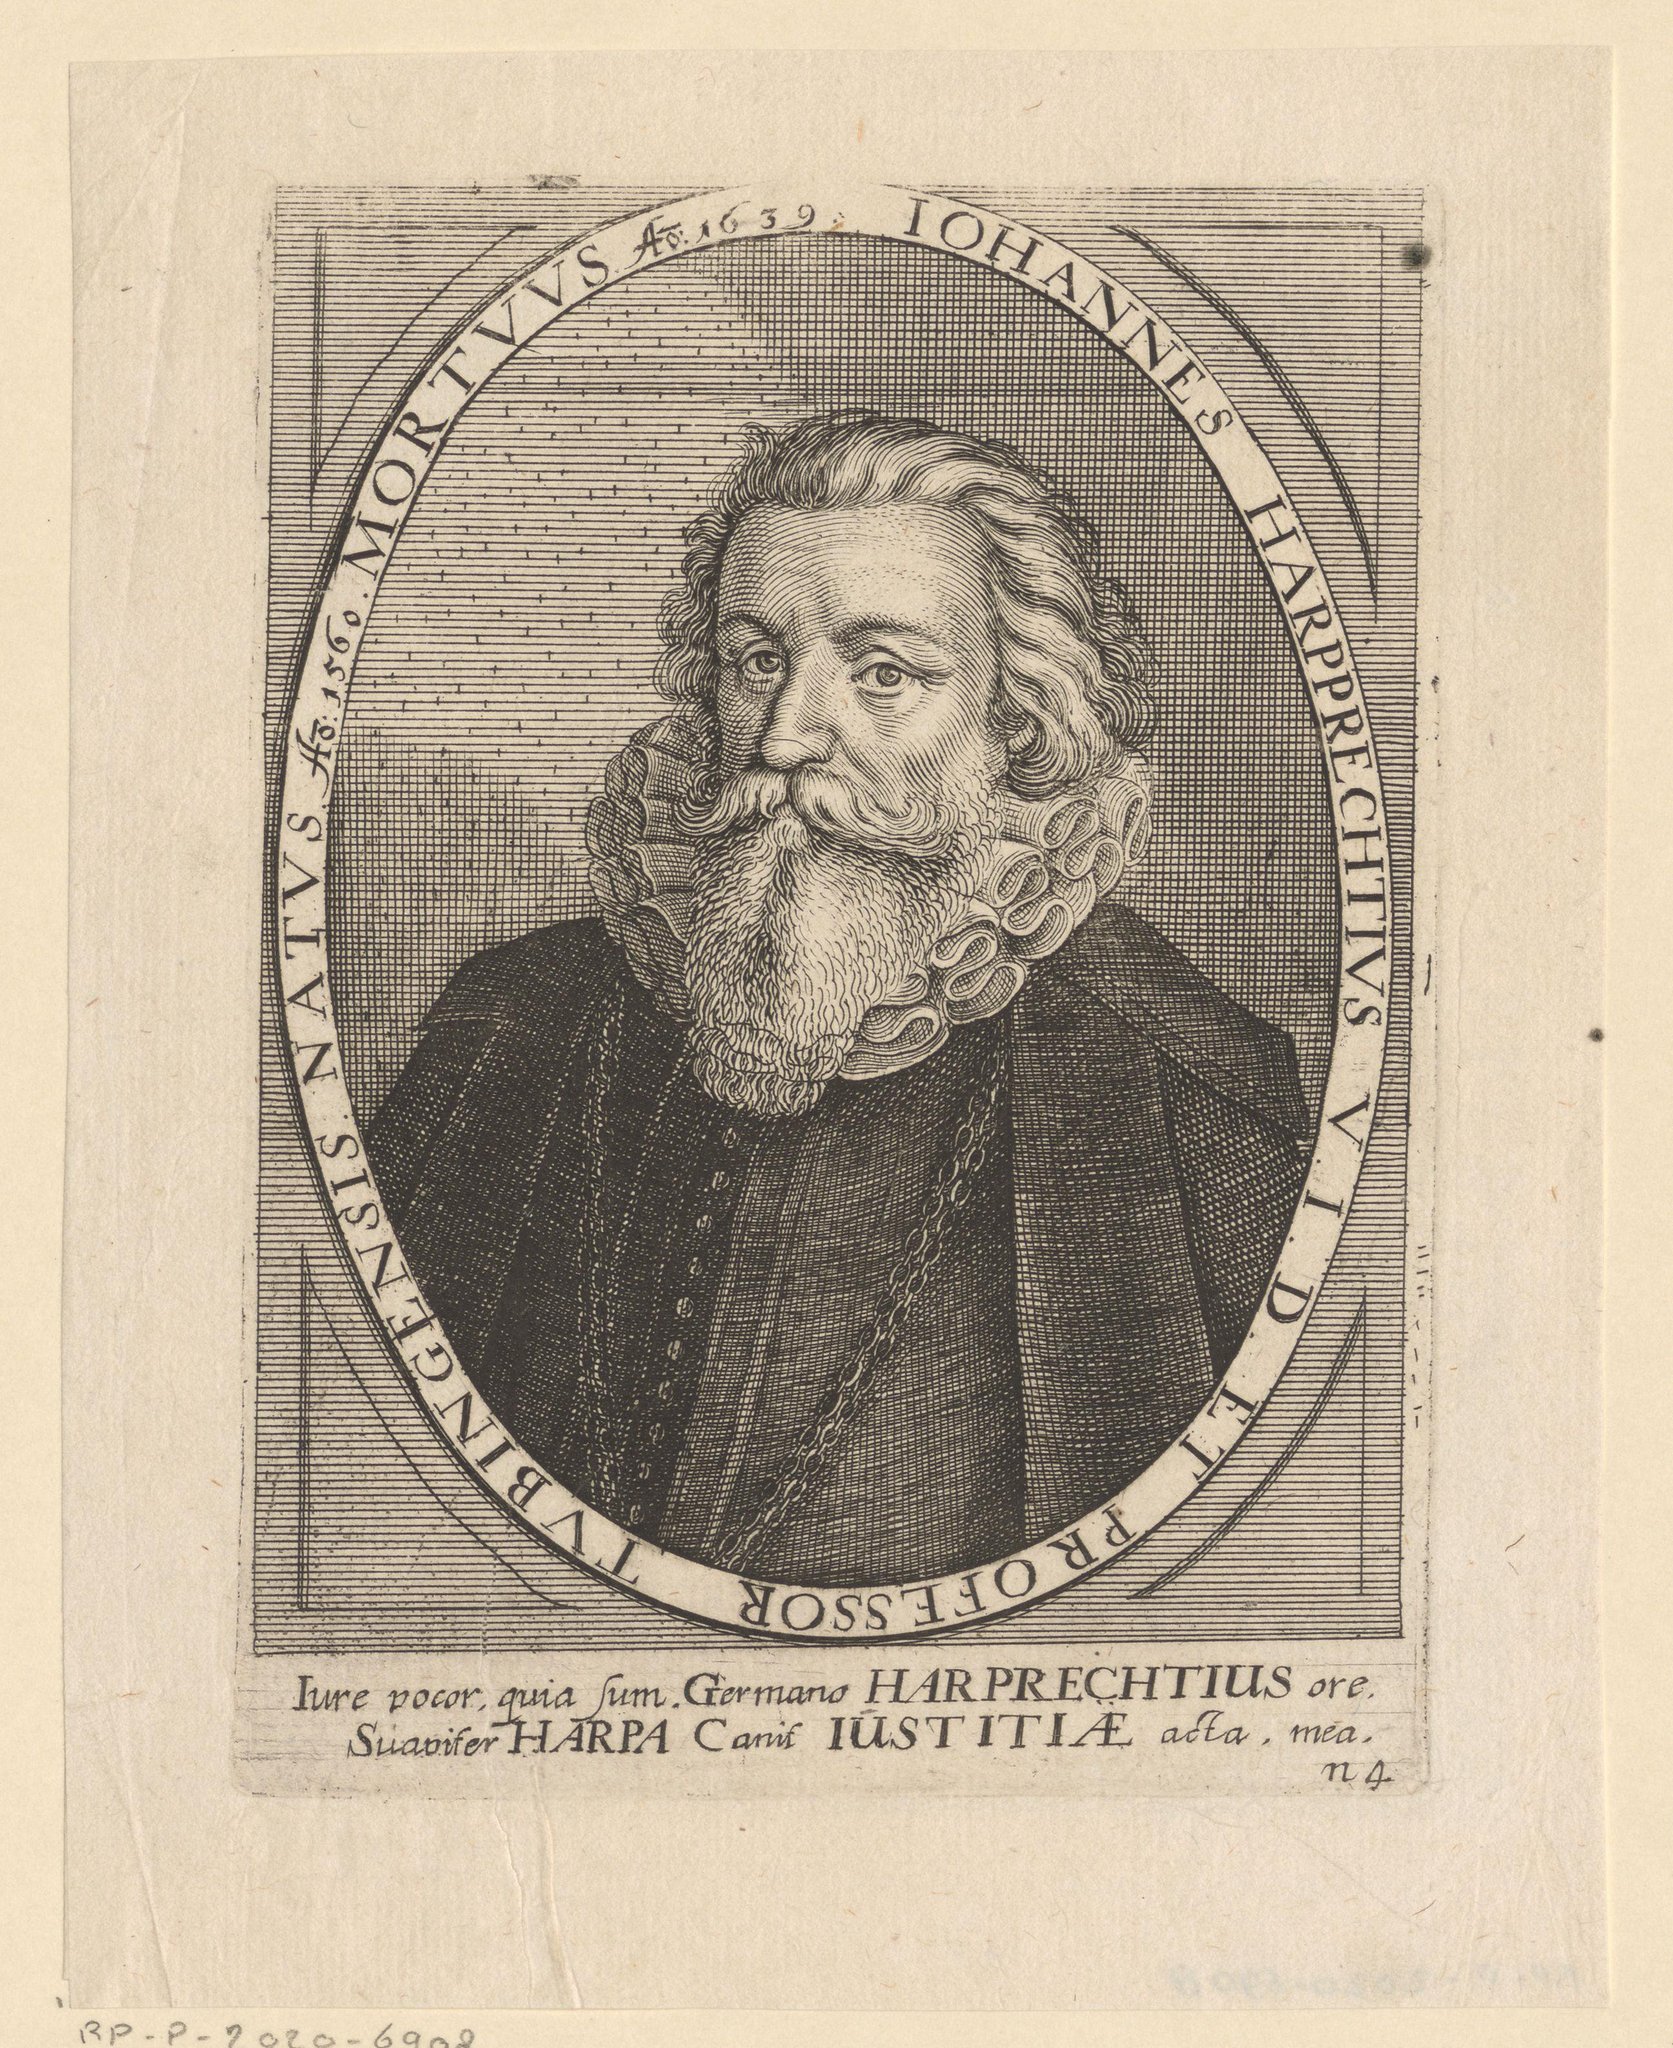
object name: print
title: Portret van Johann Harpprecht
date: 1650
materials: paper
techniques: engraving, etching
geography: frankfurt am main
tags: historical persons, lawyer, attorney at law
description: Prent uit: Bibliotheca chalcographica. Frankfurt am Main: Johannes Ammon, 1650, dl. 6.